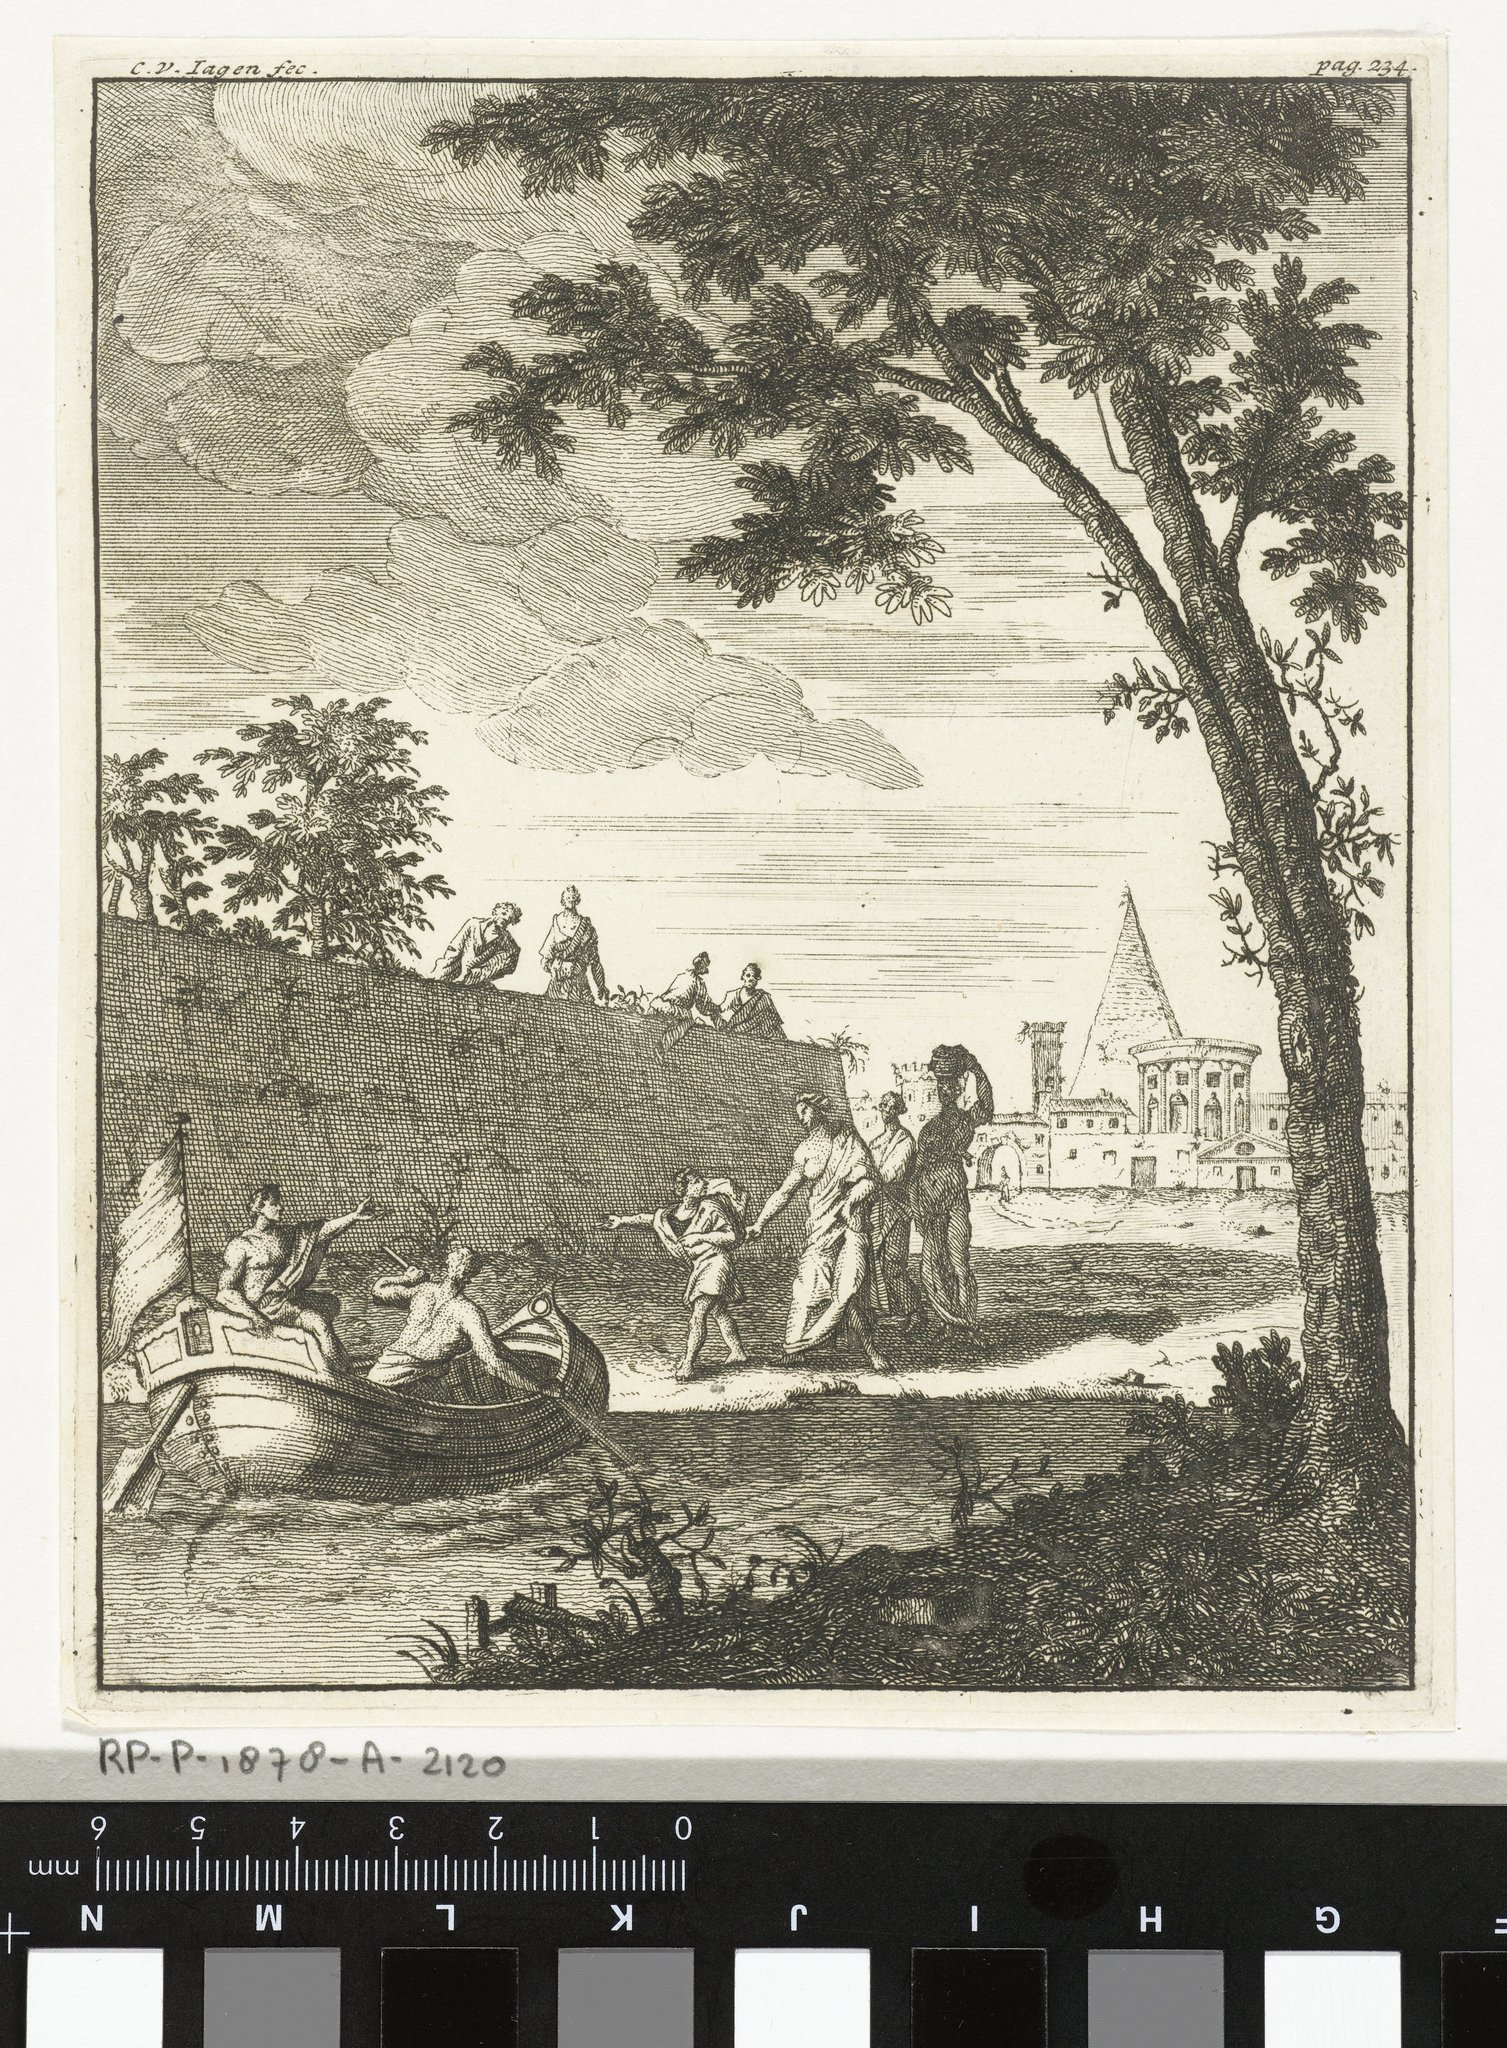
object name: print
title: Landschap met boot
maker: cornelis van jagen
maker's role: print maker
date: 1706-1744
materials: paper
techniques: etching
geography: amsterdam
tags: landscapes (+ landscape with figures, staffage)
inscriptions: collector's mark: Lugt 2228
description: Landschap met een sloep en diverse figuren. Rechts op de voorgrond een boom en op de achtergrond gezicht op een stadspoort en klassieke gebouwen. Rechtsboven: pag. 234.